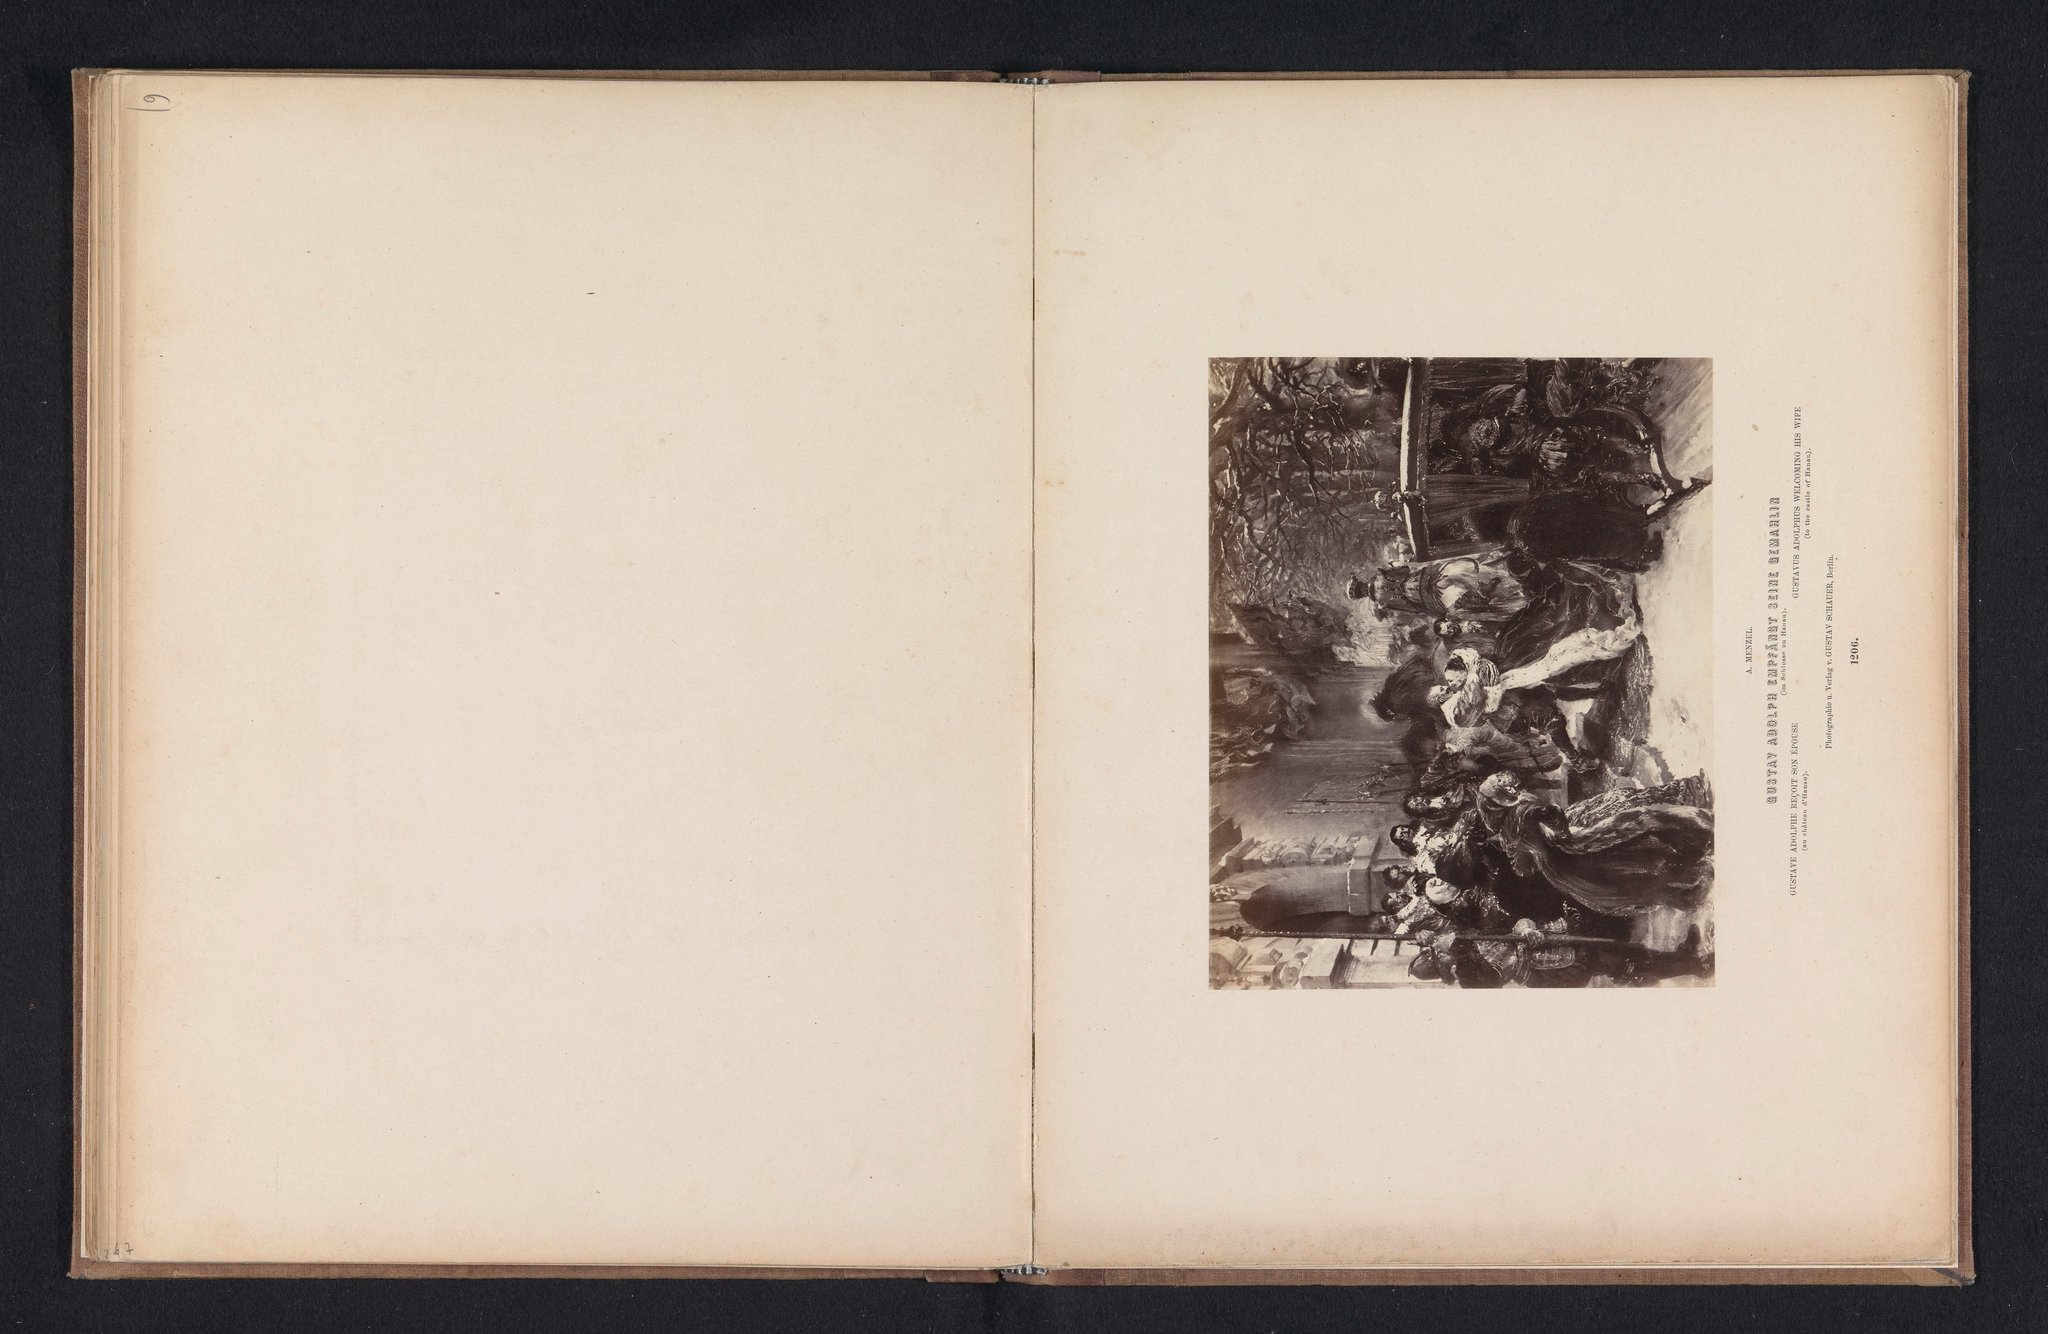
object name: photograph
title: Fotoreproductie van een schilderij van Gustaaf II Adolf die zijn vrouw ontvangt door Adolf Menzel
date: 1858-1868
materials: photographic support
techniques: albumen print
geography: berlin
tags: ruler, sovereign, lovers' meeting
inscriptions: number: ‘1206.’